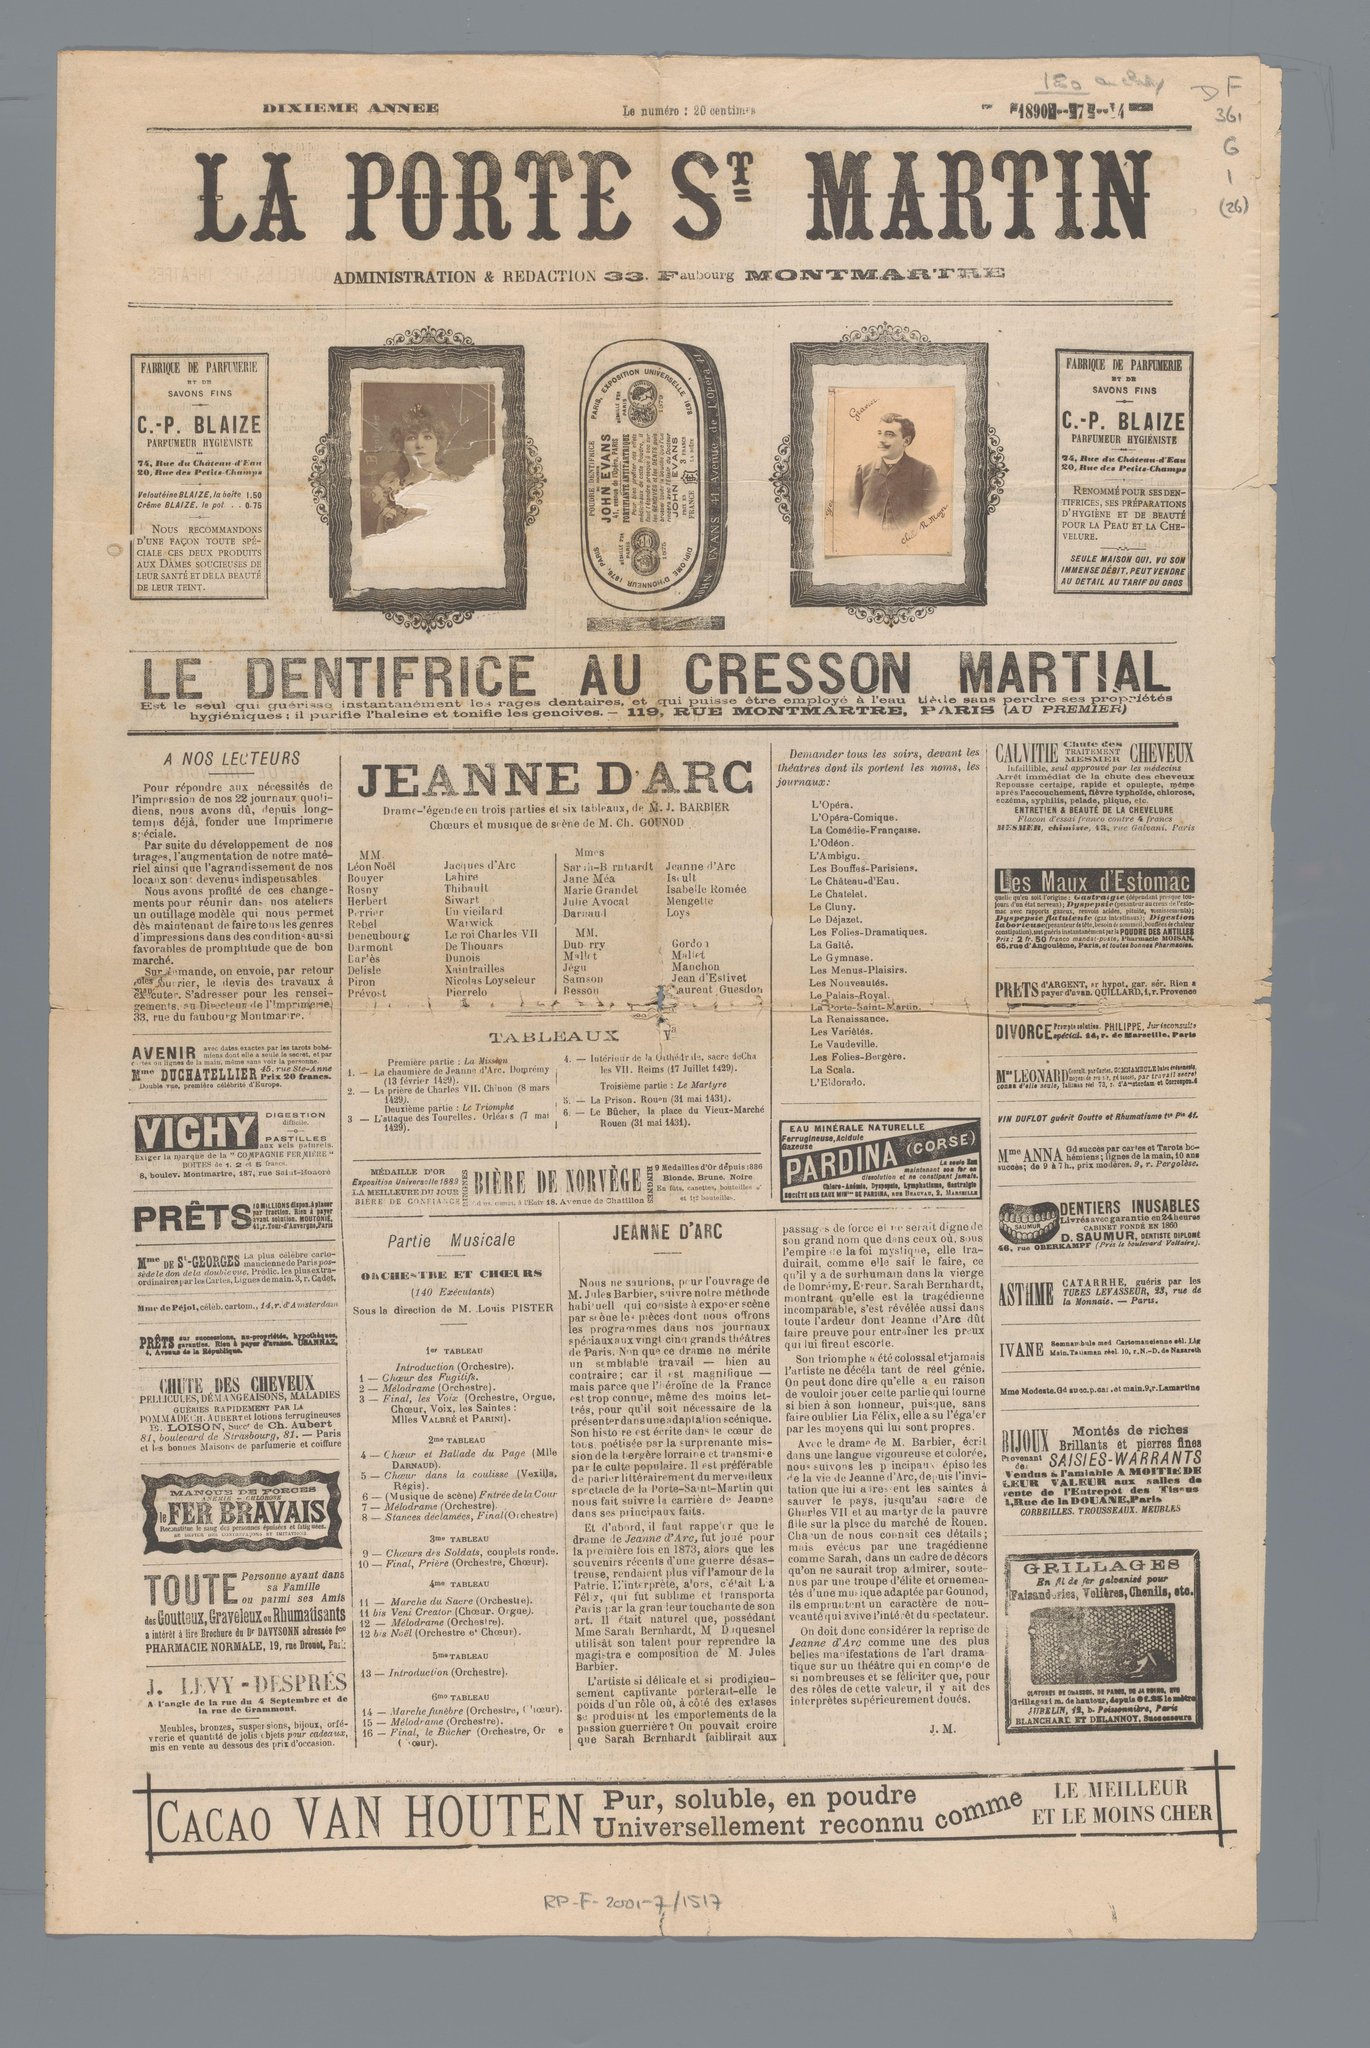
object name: page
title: Portret van Sarah Bernhardt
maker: Anonymous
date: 1885-1890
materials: paper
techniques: photograph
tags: paris, sarah bernhardt, historical persons - bb - woman, portrait of actor, actress